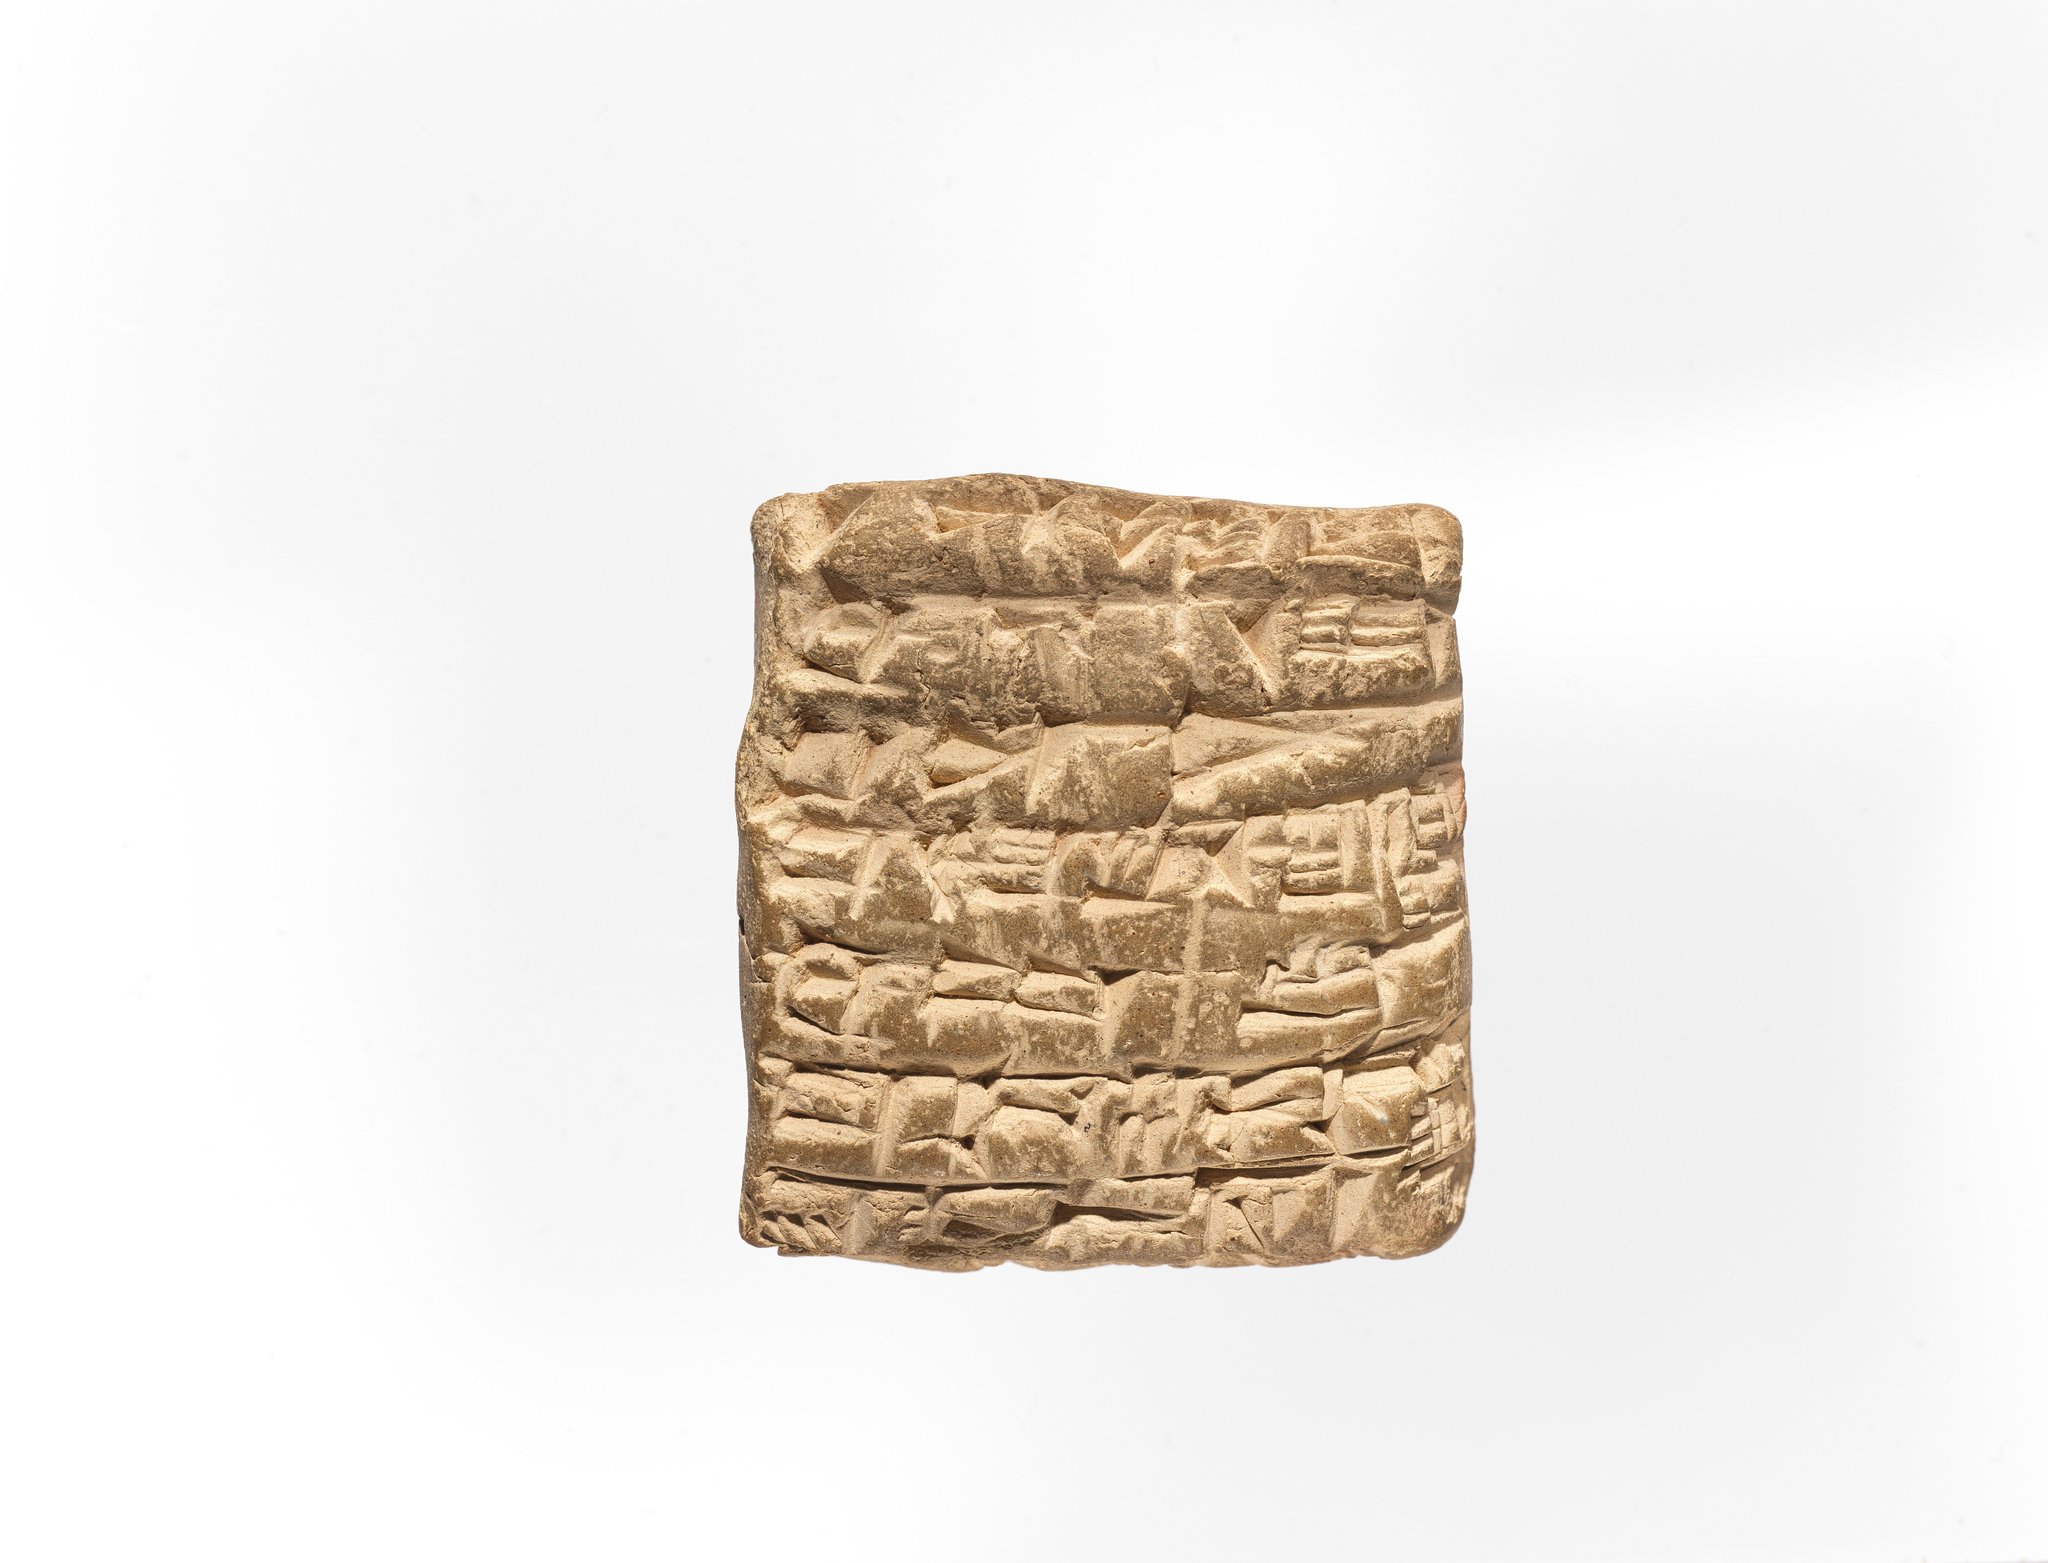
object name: cuneiform tablet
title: Cuneiform tablet: list of items for the throne of Gunura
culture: neo-sumerian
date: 2112-2004 BCE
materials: clay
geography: mesopotamia